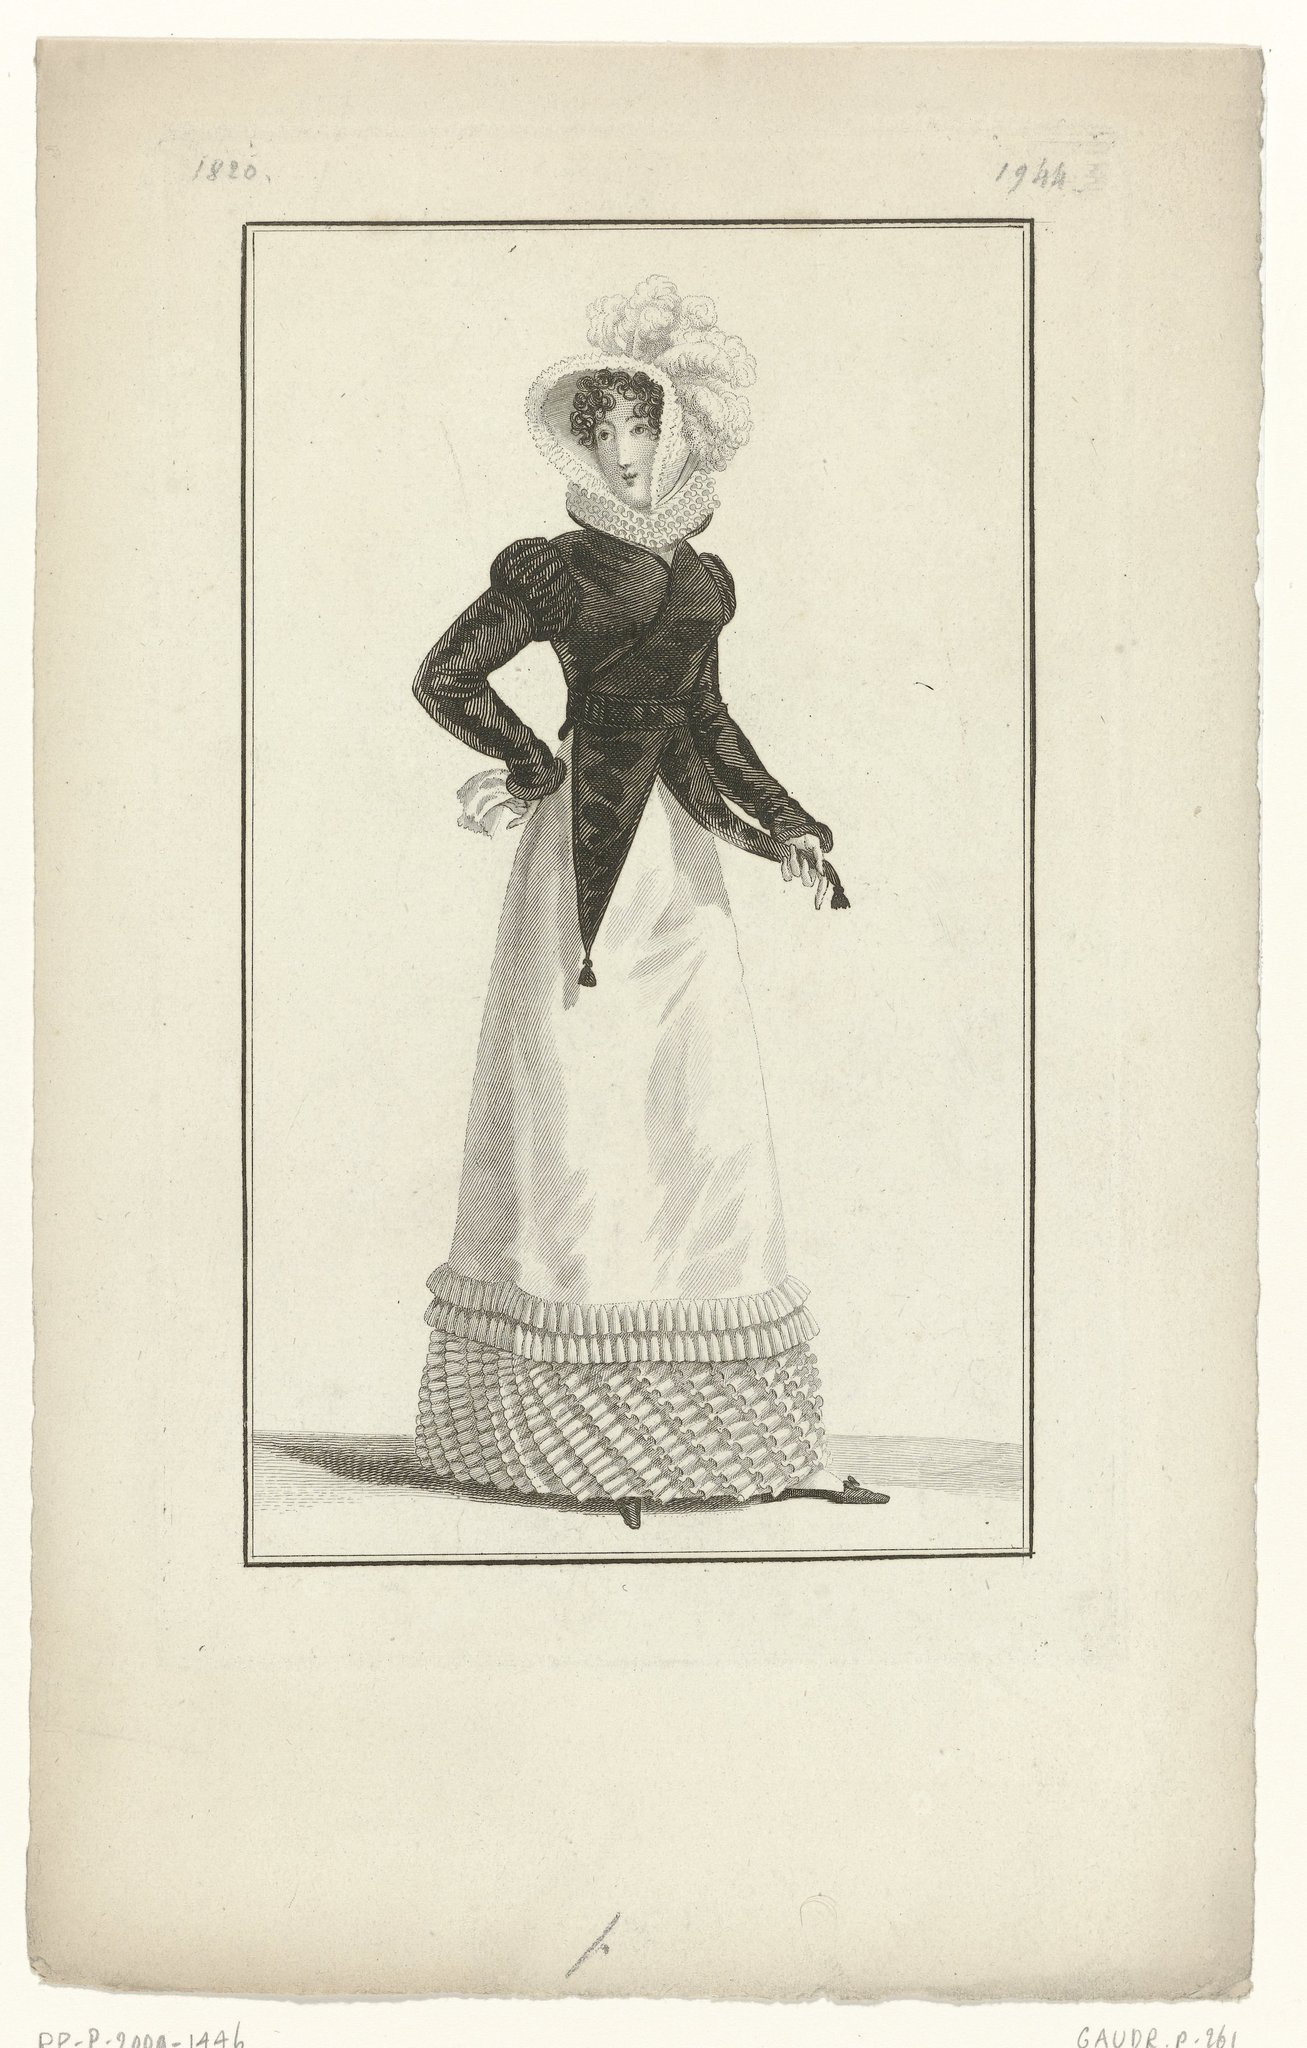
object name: fashion print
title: Journal des Dames et des Modes, Costume Parisien, 25 novembre 1820, (1944)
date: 1820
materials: paper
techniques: engraving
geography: paris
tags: handkerchief (+ women's clothes), clothing for the upper part of the body (spencer) (+ women's clothes), fashion plates, head-gear: hat (+ women's clothes), shoes, sandals (+ women's clothes), neck-gear ~ clothing (with name) (+ women's clothes), dress, gown (+ women's clothes)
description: Vrouw met op het hoofd een hoed van 'pluche de soie bouclée' versierd met maraboeveren. Zij draagt een spencer met overslag, uitlopend in twee punten met kwasten. Hieronder een japon van katoenbatist (percale) versierd met geplooide stroken mousseline. Verdere accessoires: zakdoek, platte schoenen met strikken. Proefdruk van een prent uit het modetijdschrift Journal des Dames et des Modes, uitgegeven door Pierre de la Mésangère, Parijs, 1797-1839.